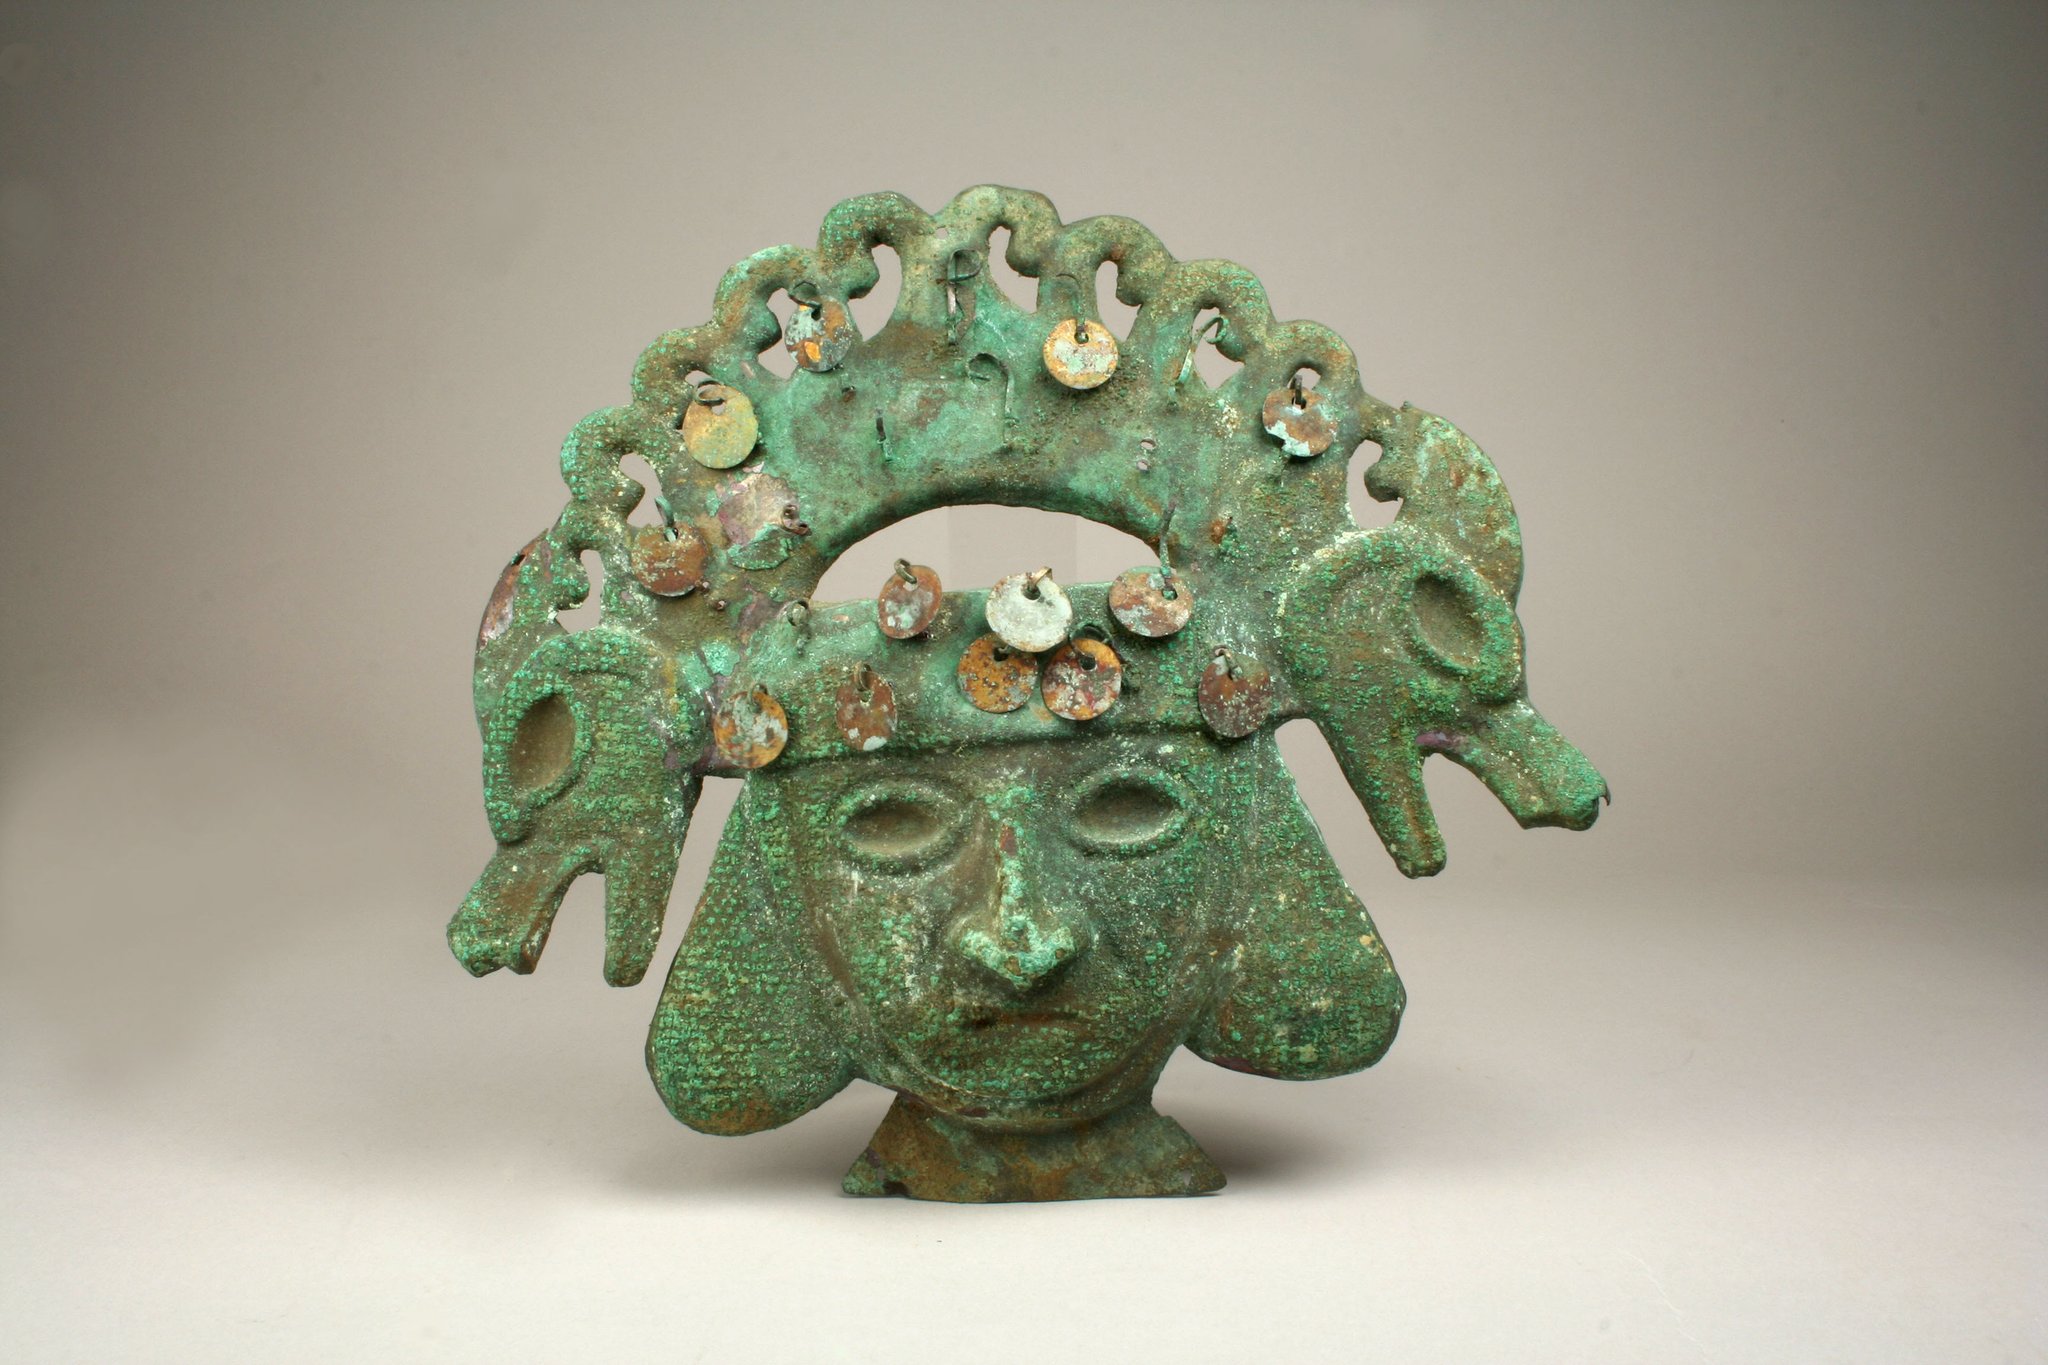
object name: ornament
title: Mask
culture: moche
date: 501-700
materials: metal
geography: peru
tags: masks